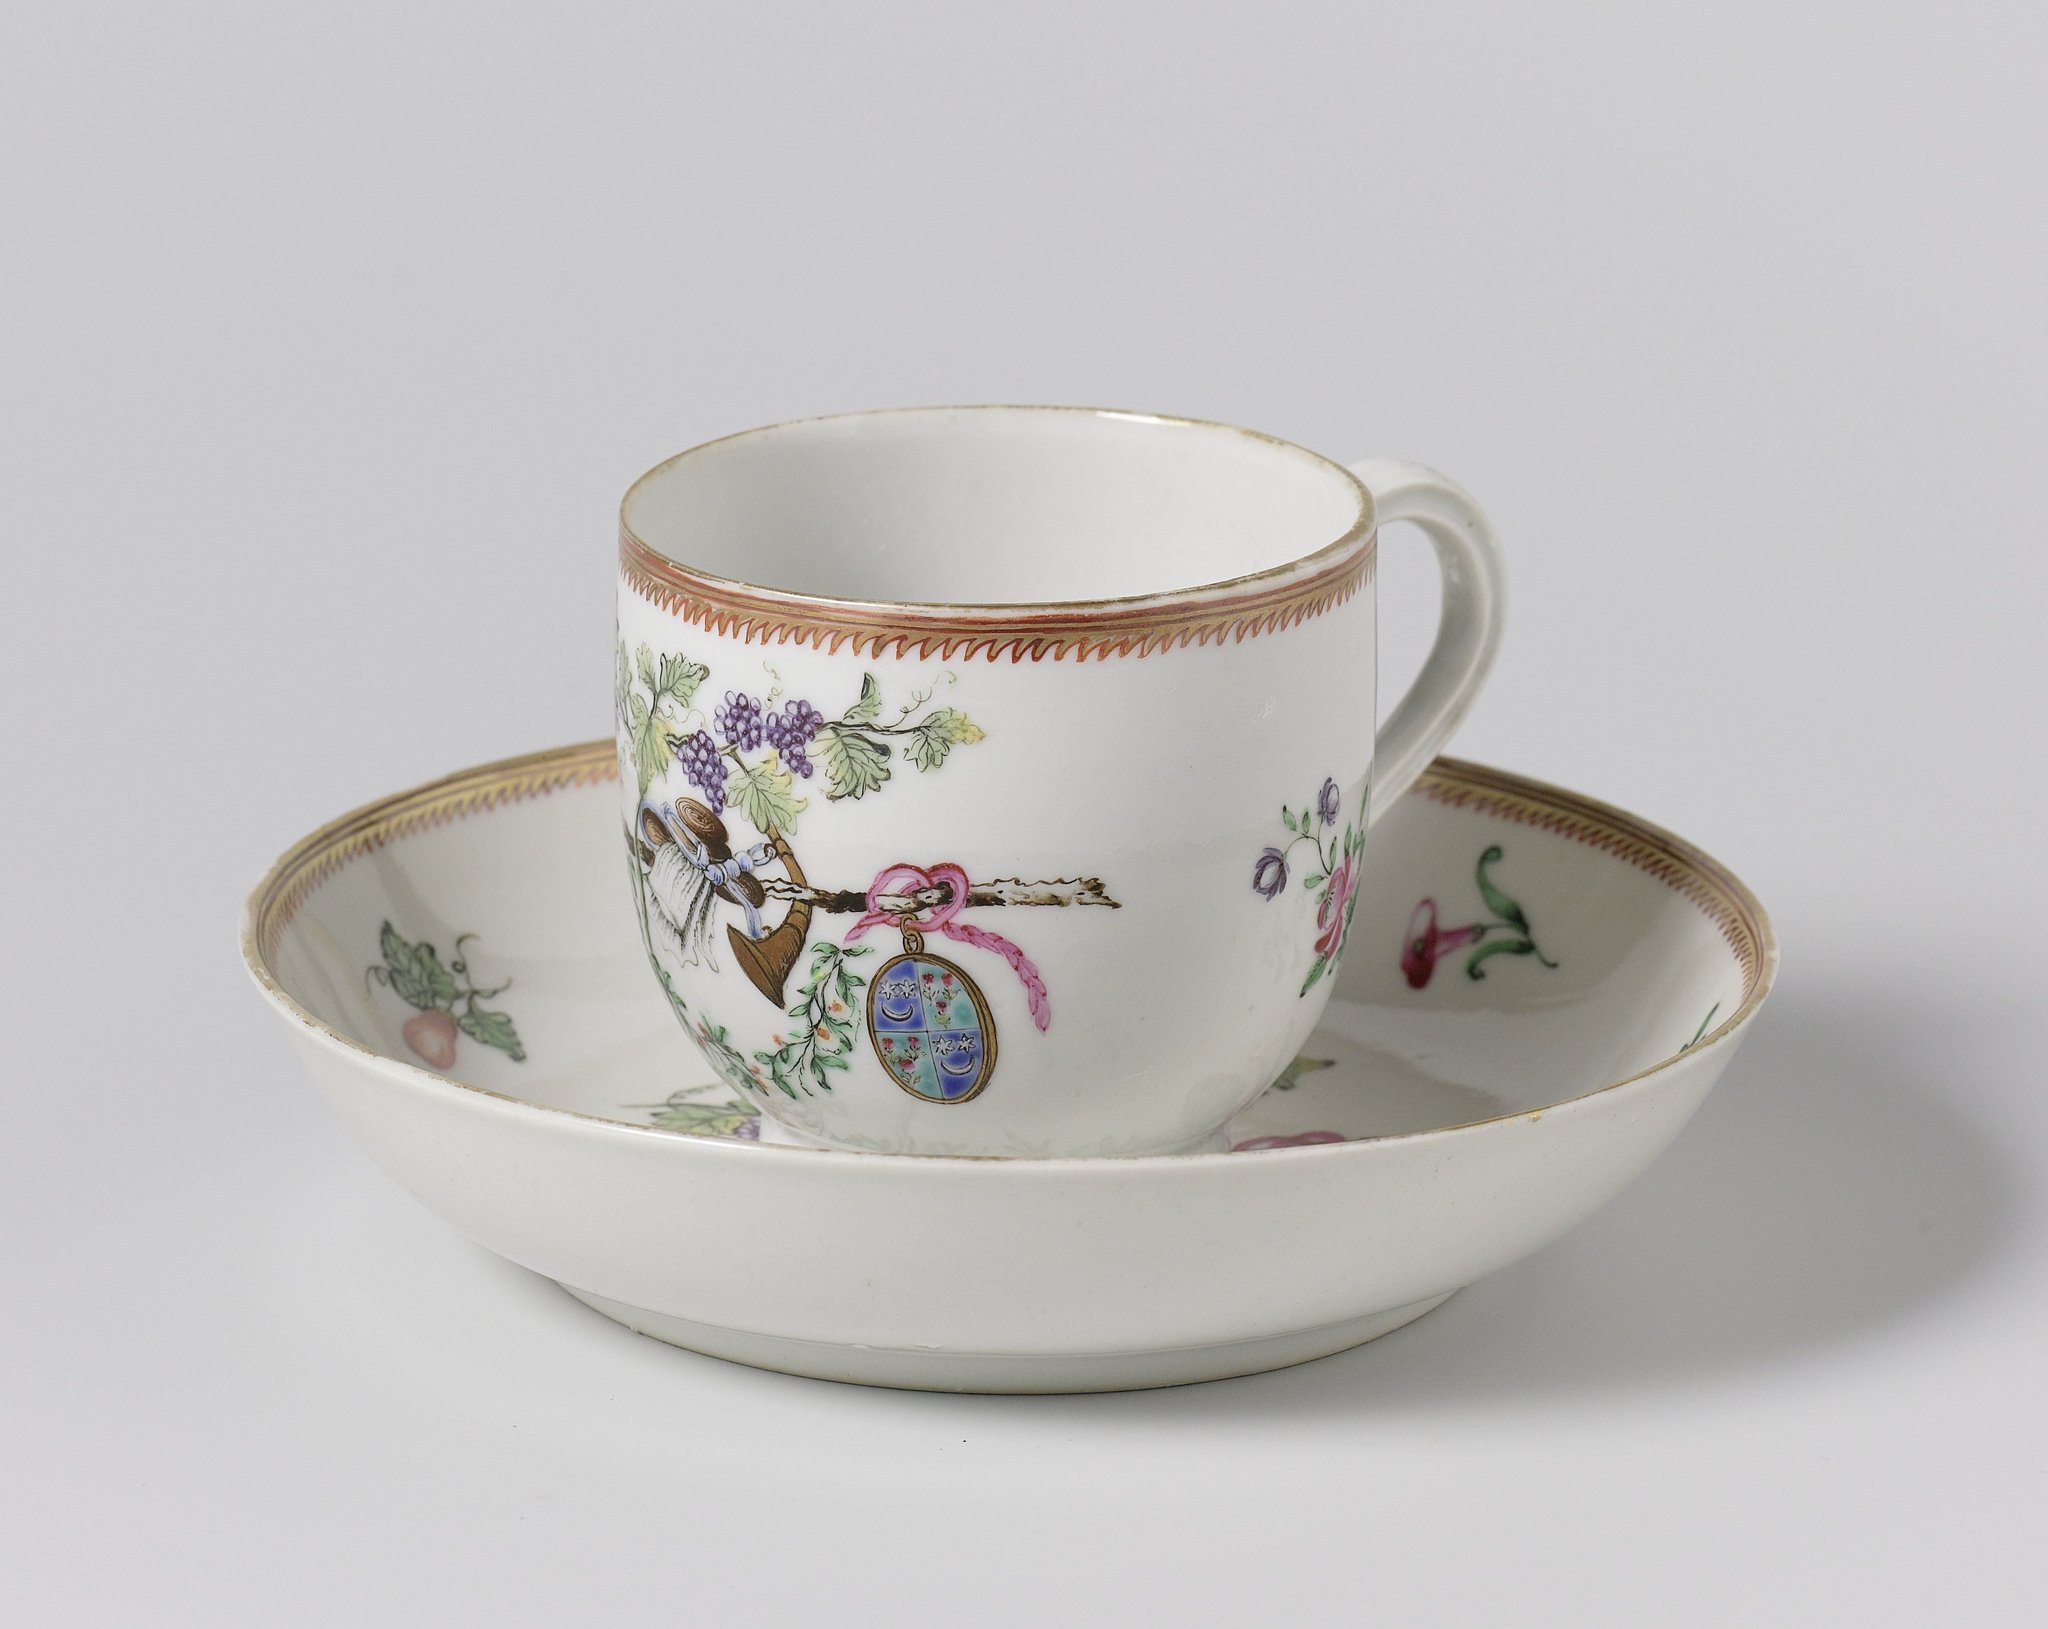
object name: kop en schotel, kop en schotel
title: Cup with handle and saucer with the arms of the Visvliet and Sluymer families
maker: Anonymous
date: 1777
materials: glaze, gold, paint, porcelain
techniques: firing, gilding, turning, vitrification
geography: china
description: Kop en schotel van porselein. Versierd met bloem- en vruchtentakken en een stok waaraan een hoed, een blad papier een hoorn en 2 wapenschilden zijn bevestigd. De wapens zijn van de families Visvliet en Sluymer (uit Zeeland).